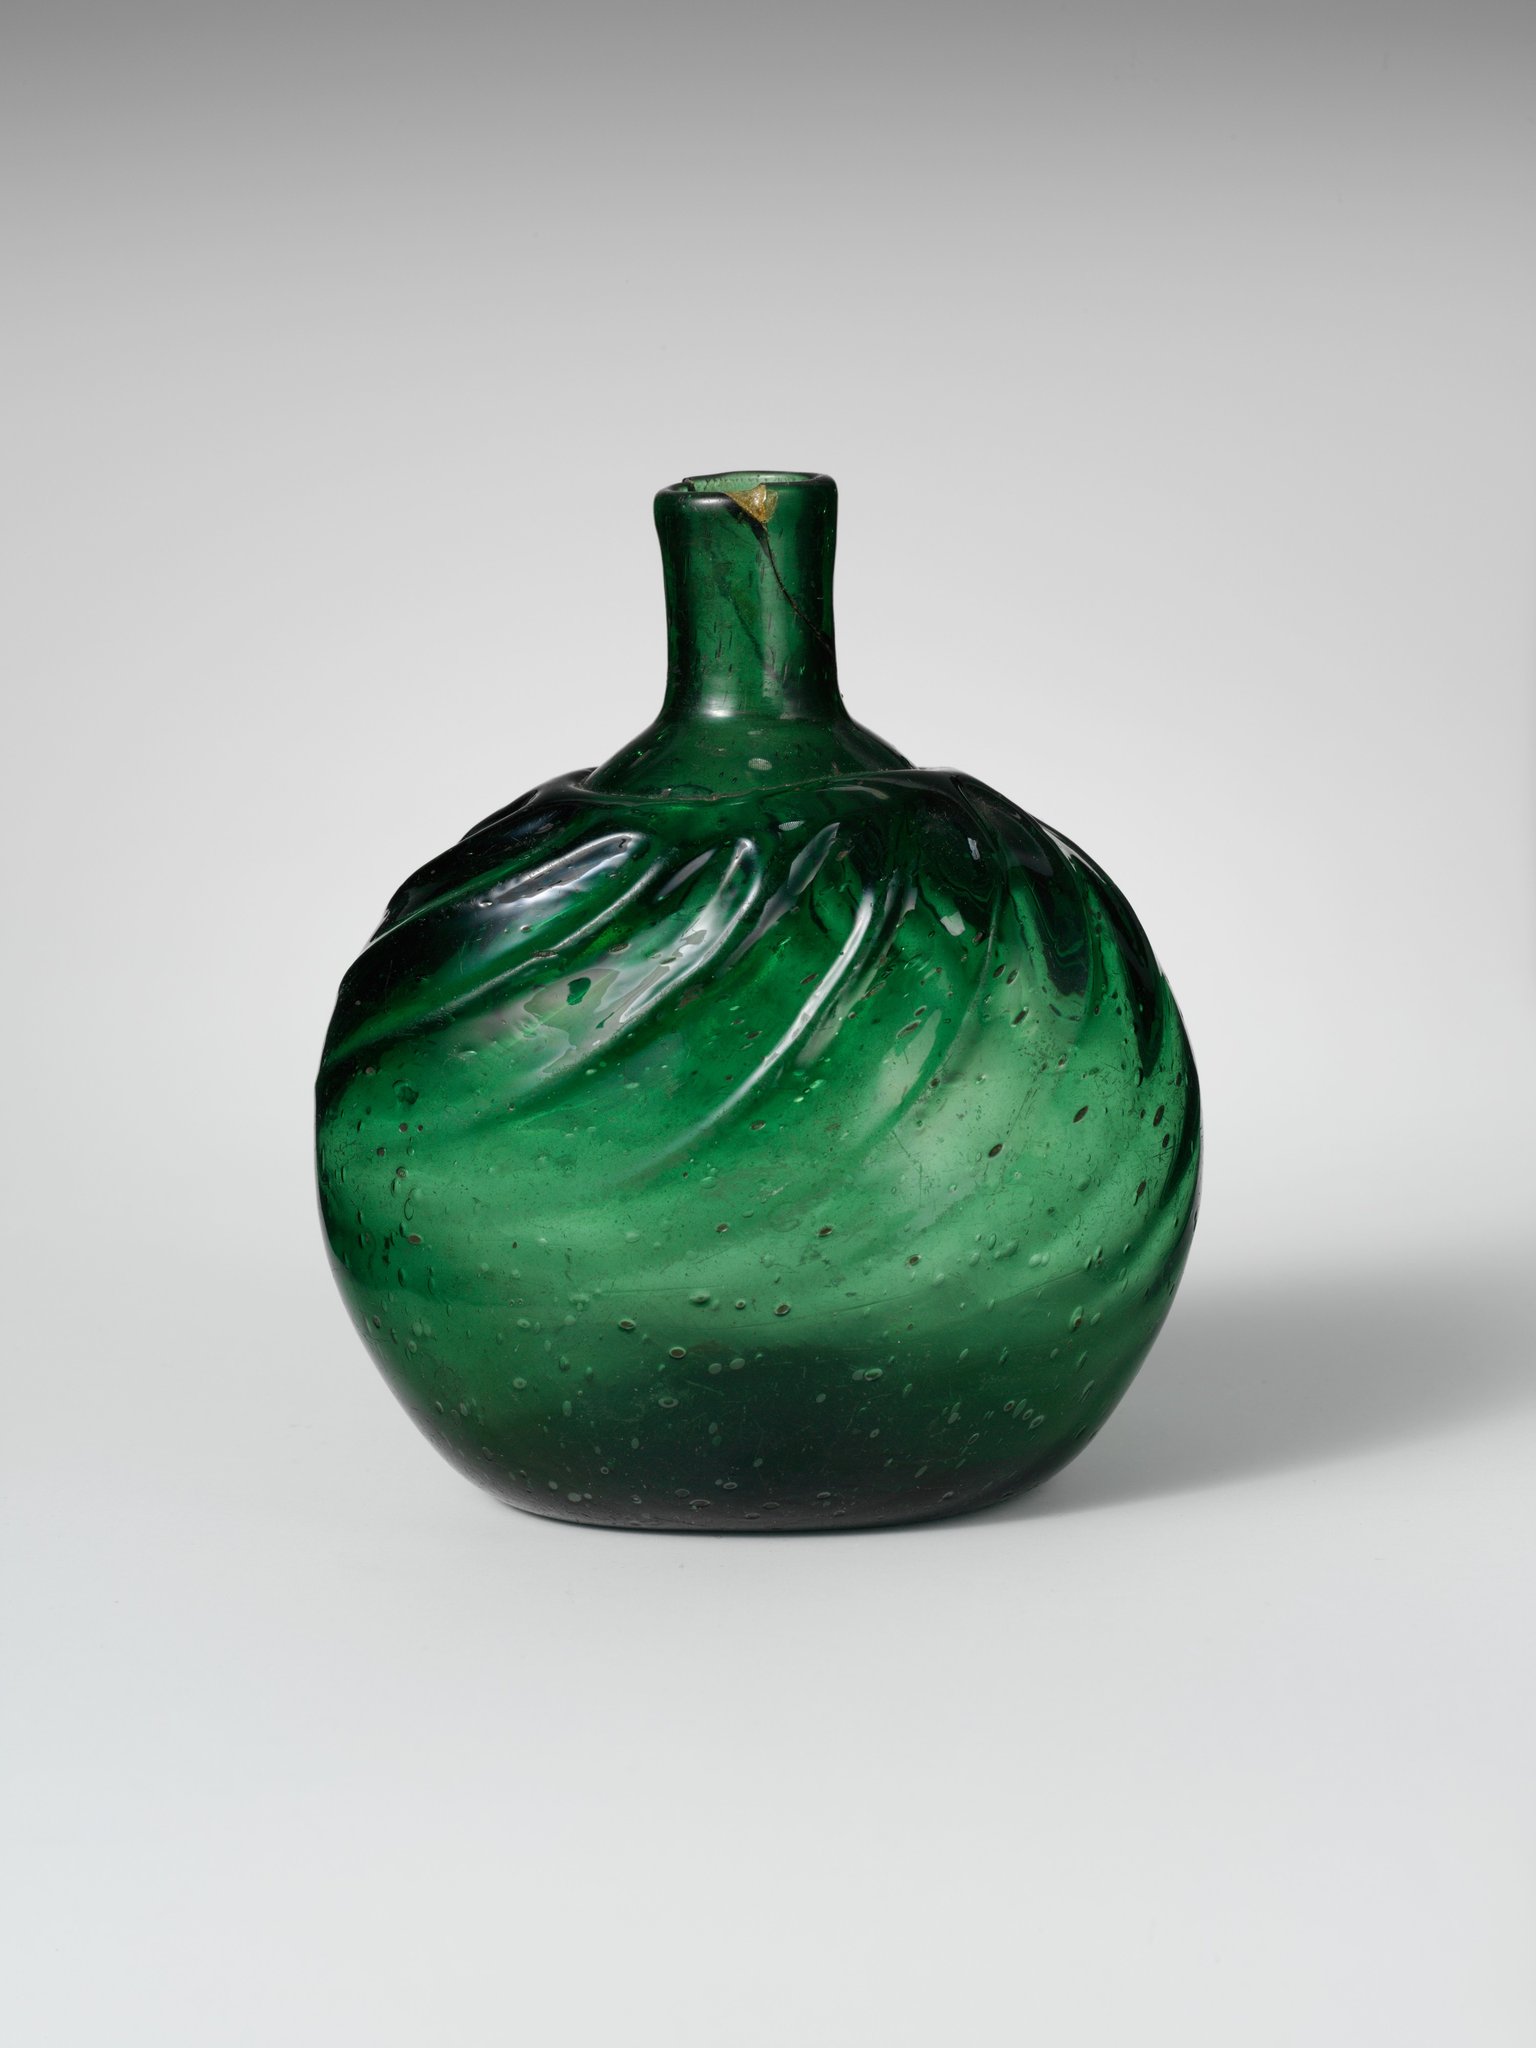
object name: bottle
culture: american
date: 1801-1900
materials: glass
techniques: glassblowing, molding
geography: united states